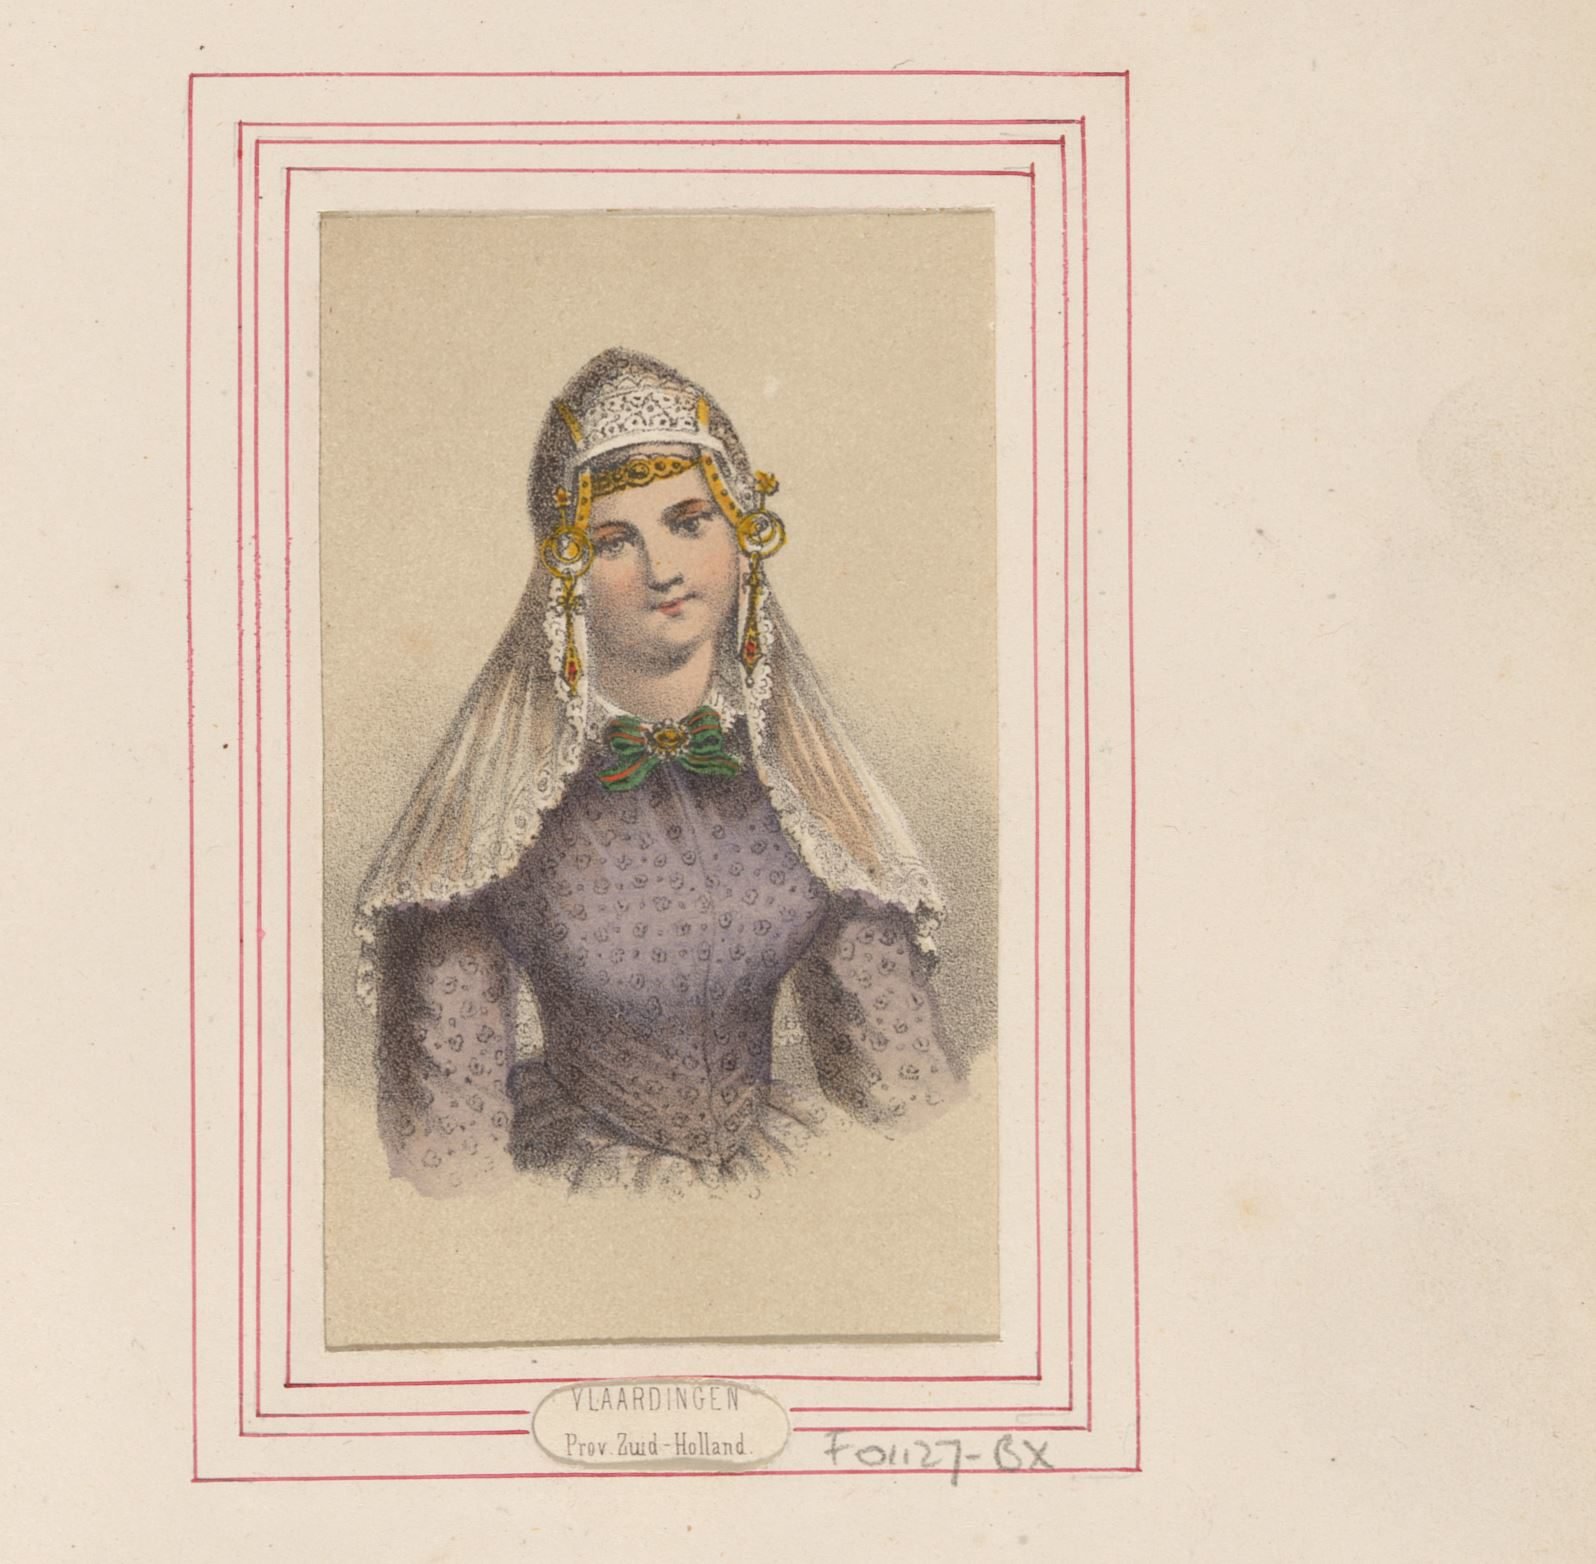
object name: print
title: Vlaardingen Prov. Zuid-Holland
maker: Anonymous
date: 1865-1875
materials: paper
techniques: lithograph, hand coloring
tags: folk costume, regional costume (+ women's clothes), head-gear: cap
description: Onderdeel van Album met foto's en litho's van bezienswaardigheden in Noord- en Zuid-Hollandse steden, schilderijen en klederdrachten.